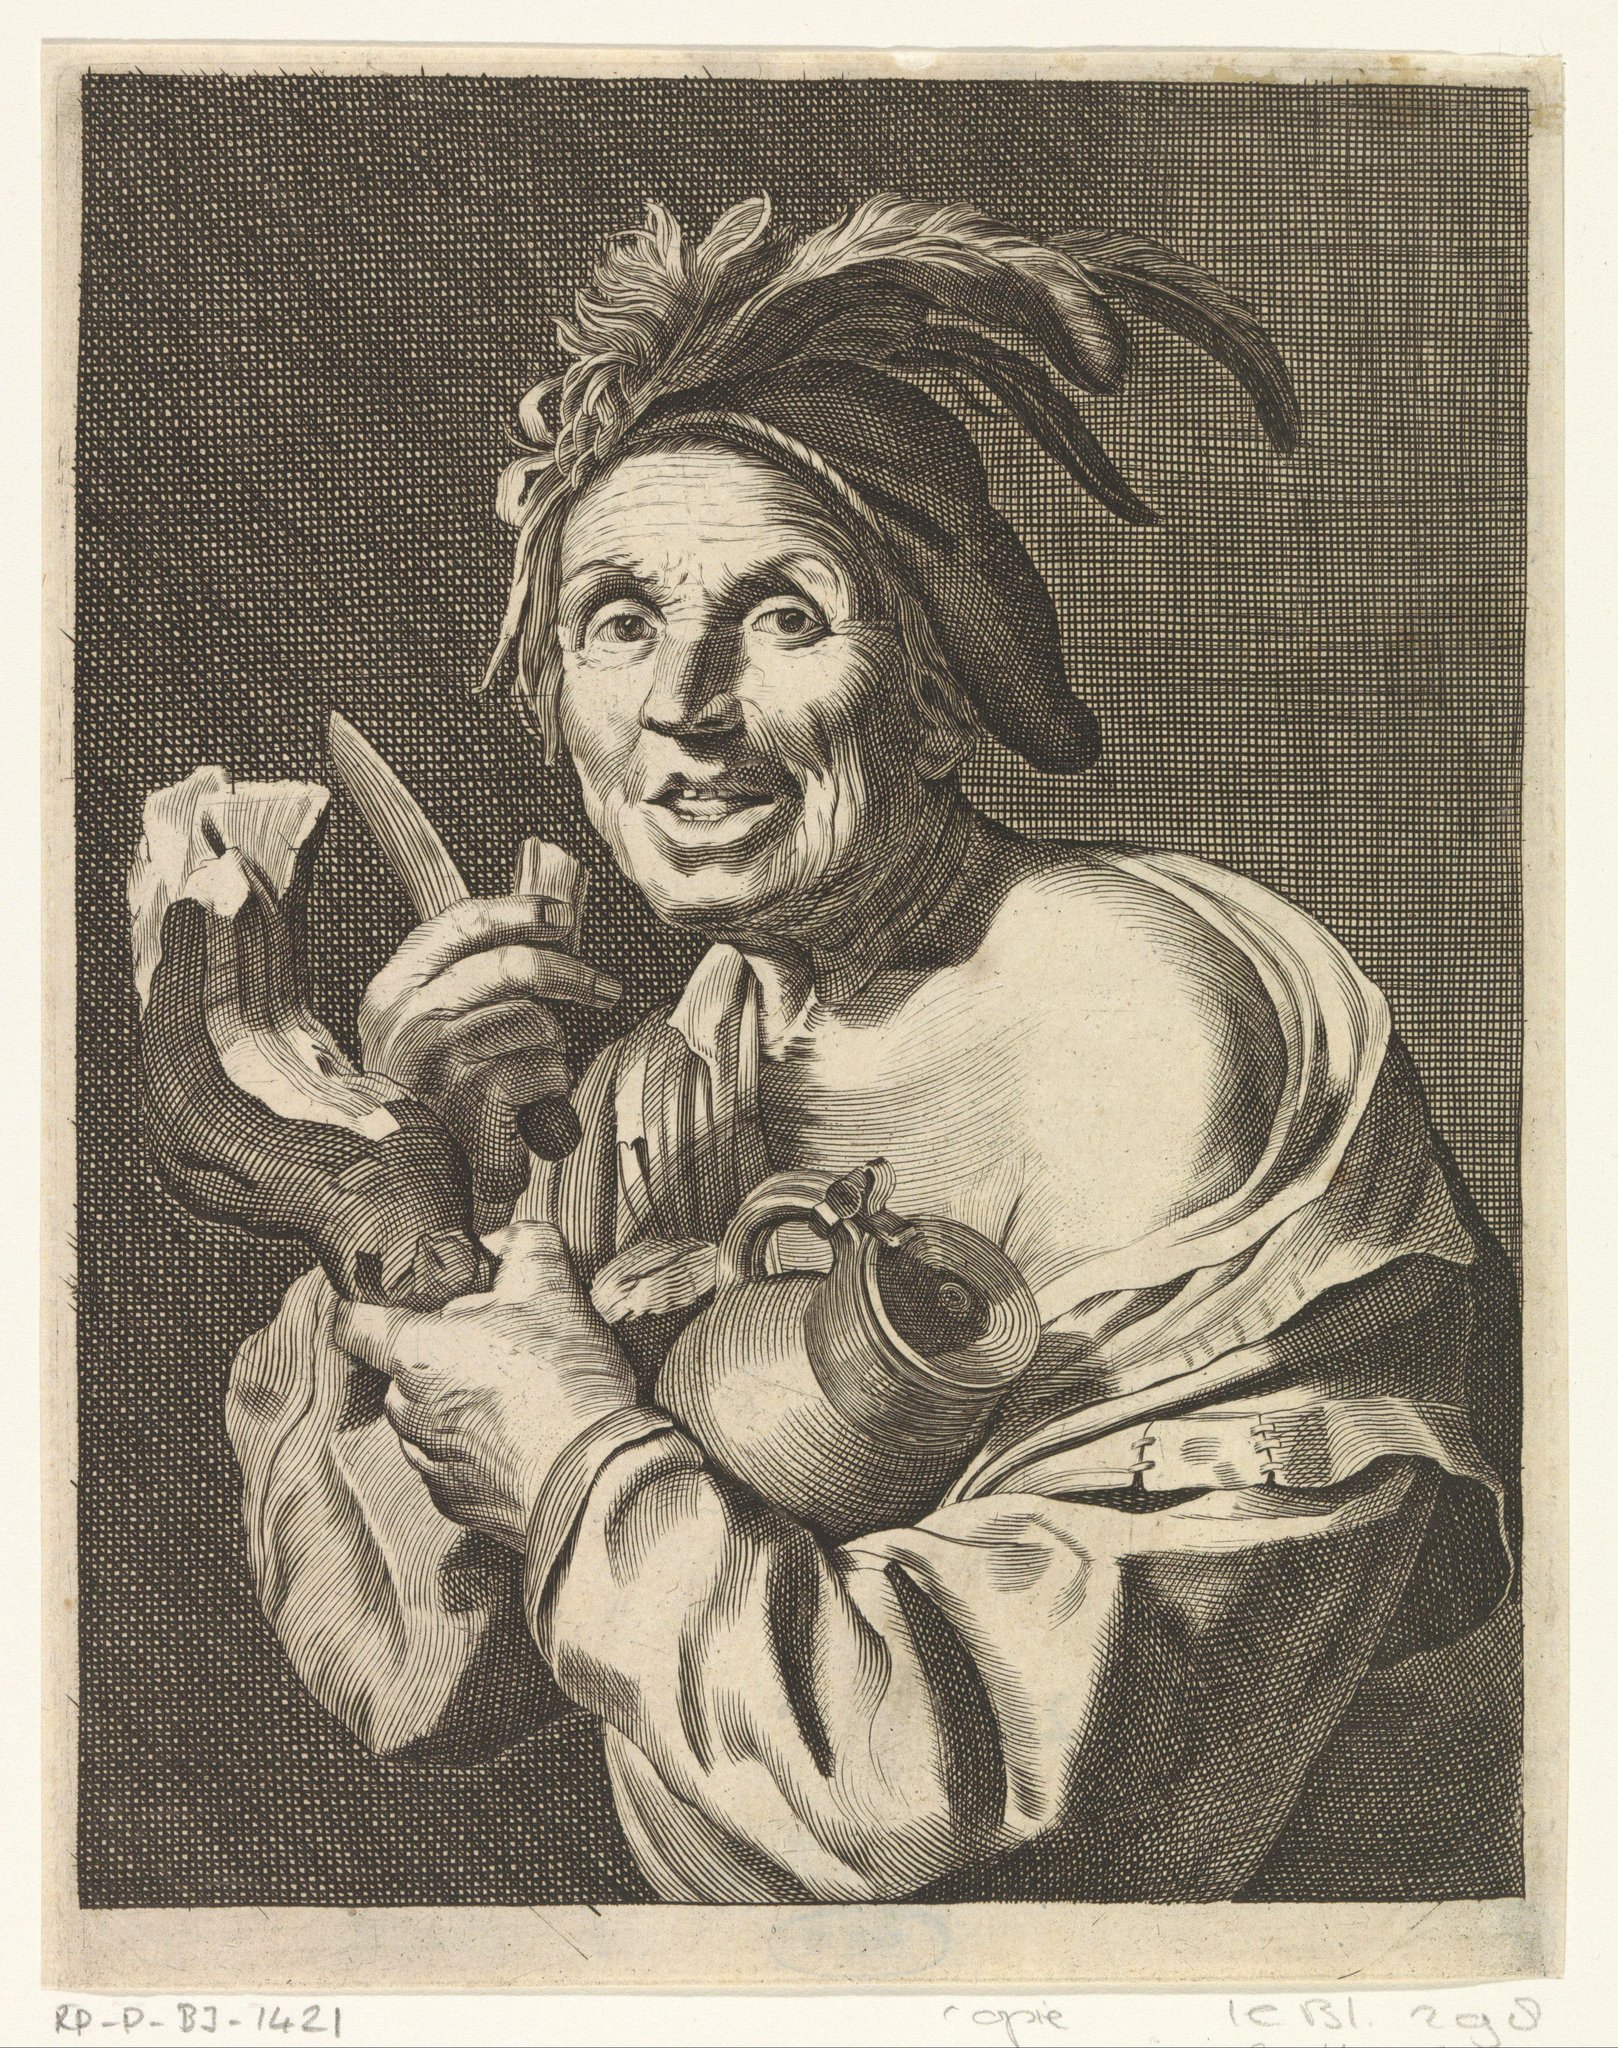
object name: print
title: Man eet ham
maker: cornelis van dalen (i)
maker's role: print maker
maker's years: 1602-1665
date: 1625-1675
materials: paper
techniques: engraving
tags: ham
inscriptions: collector's mark: Lugt 2228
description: Een man heeft in de linkerarm een kruik en een aangesneden ham. Met zijn rechterhand brengt hij een stuk ham naar zijn mond.